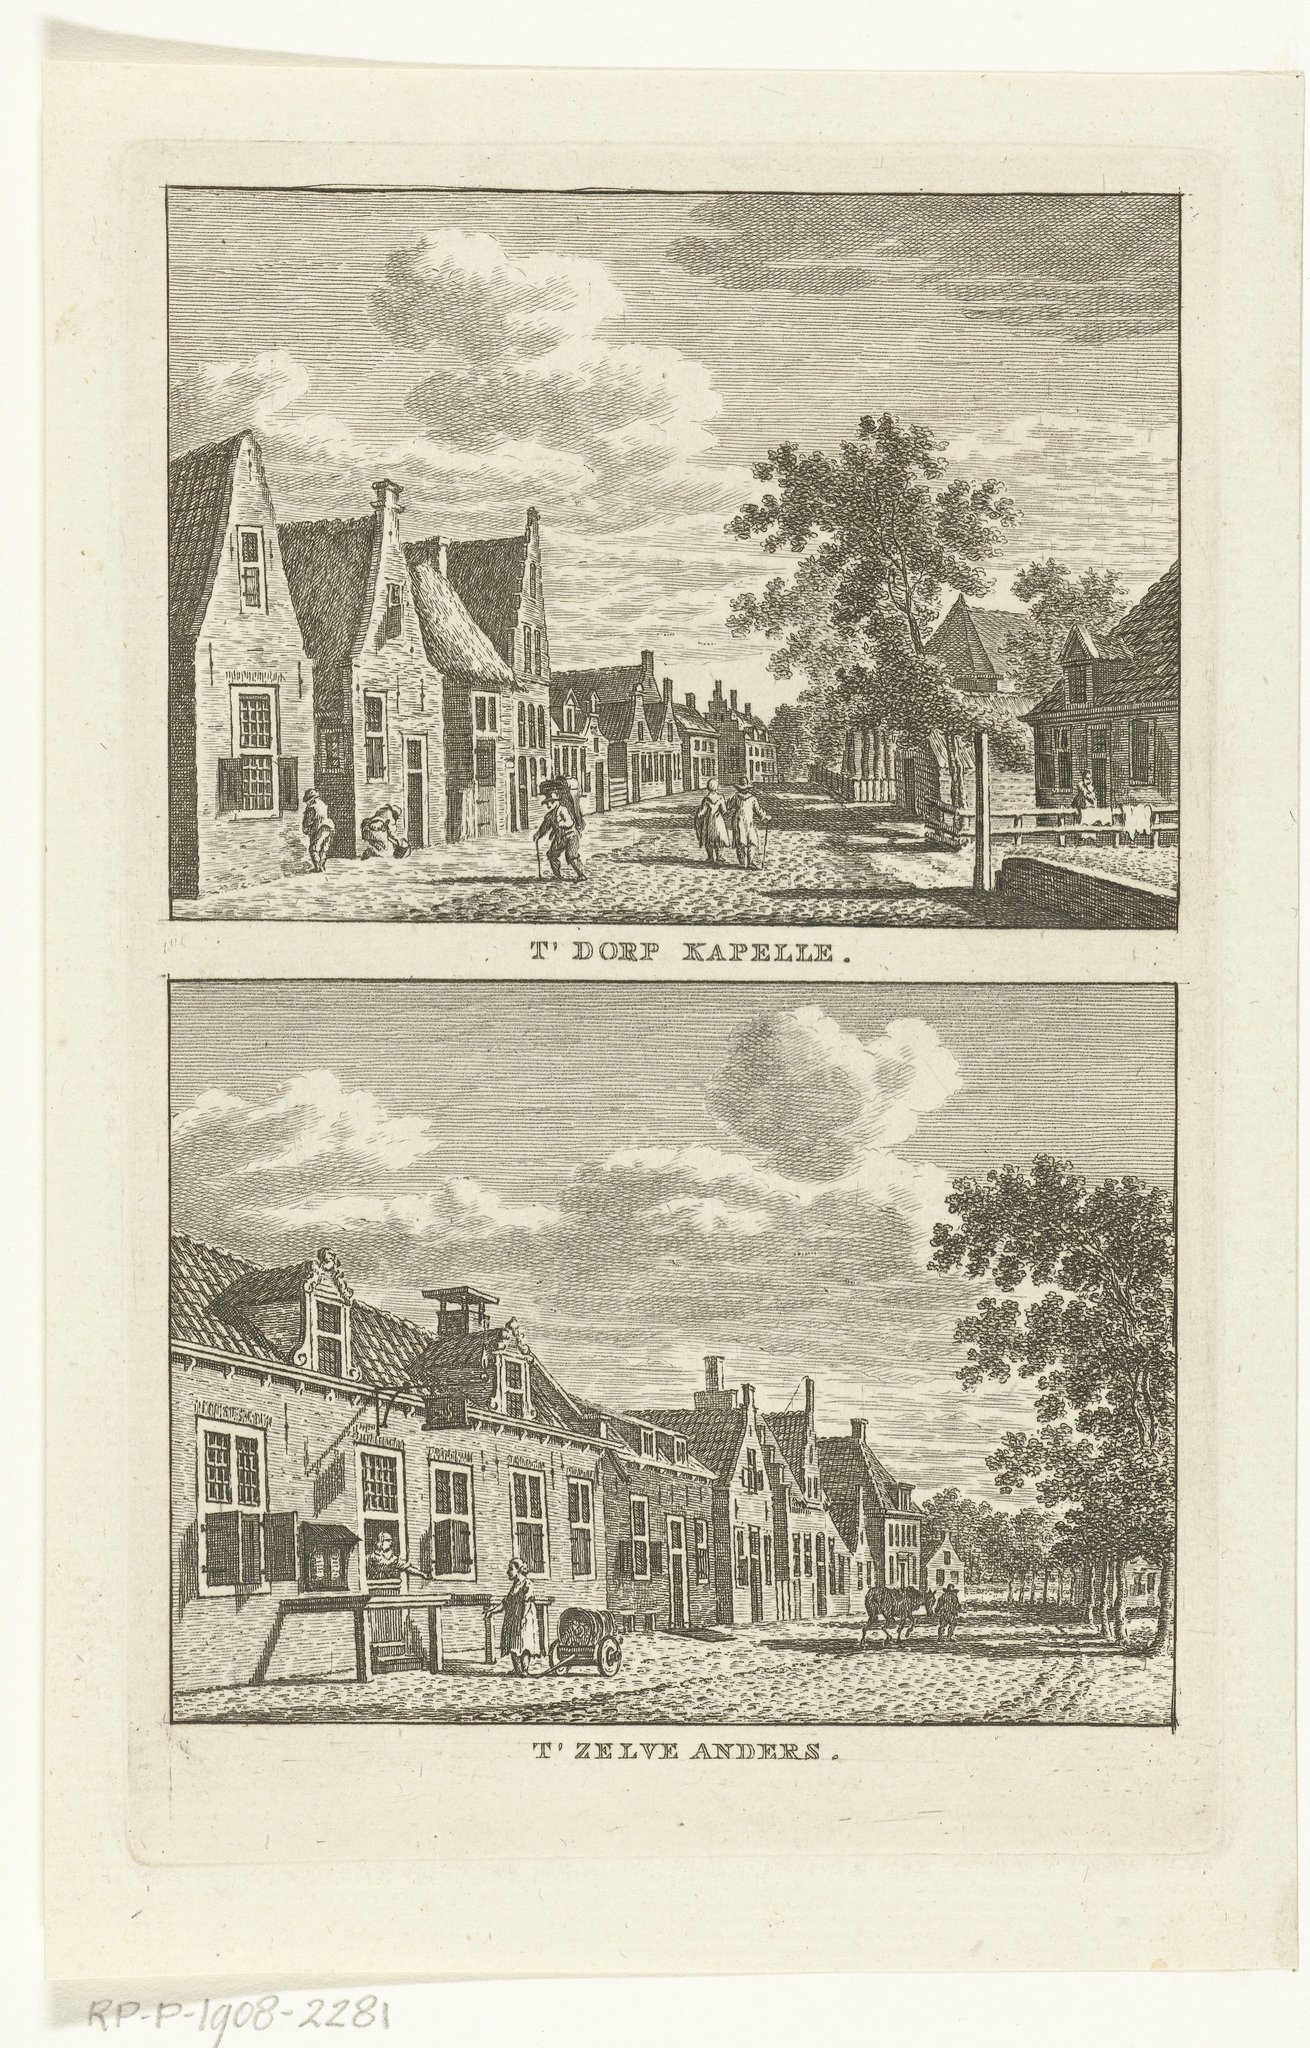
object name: print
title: T' Dorp Kapelle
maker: carel frederik bendorp (i)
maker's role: print maker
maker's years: 1736-1814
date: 1786-1792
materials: paper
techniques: etching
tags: village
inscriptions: collector's mark: Lugt 2228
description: Prent uit: Vaderlandsche gezichten, of afbeeldingen van den tegenwoordigen staat der Vereenigde Nederlanden (…). Amsterdam: Hendrik Gartman, Willem Vermandel en Jan Willem Smit, 1786-1792. Uitgegeven in afleveringen met ieder een eigen bifolium en inhoudsopgave. Alle prenten in deze publicatie zijn gegraveerd door Carel Frederik Bendorp (I) en, in de meeste gevallen, gebaseerd op tekeningen van Jan Bulthuis.